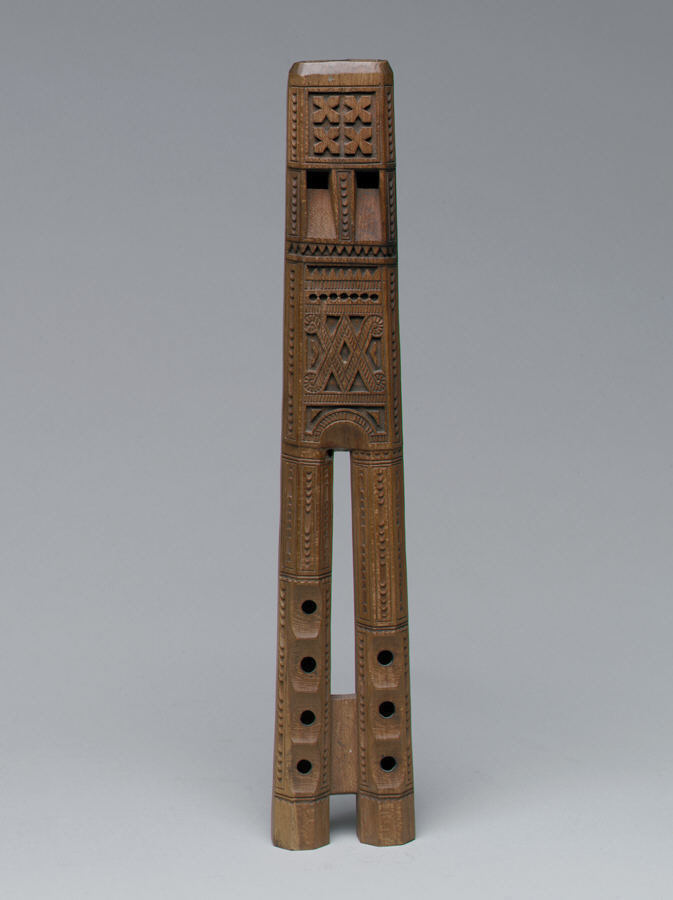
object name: dvojnice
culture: bosnian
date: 1867-1900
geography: bosnia